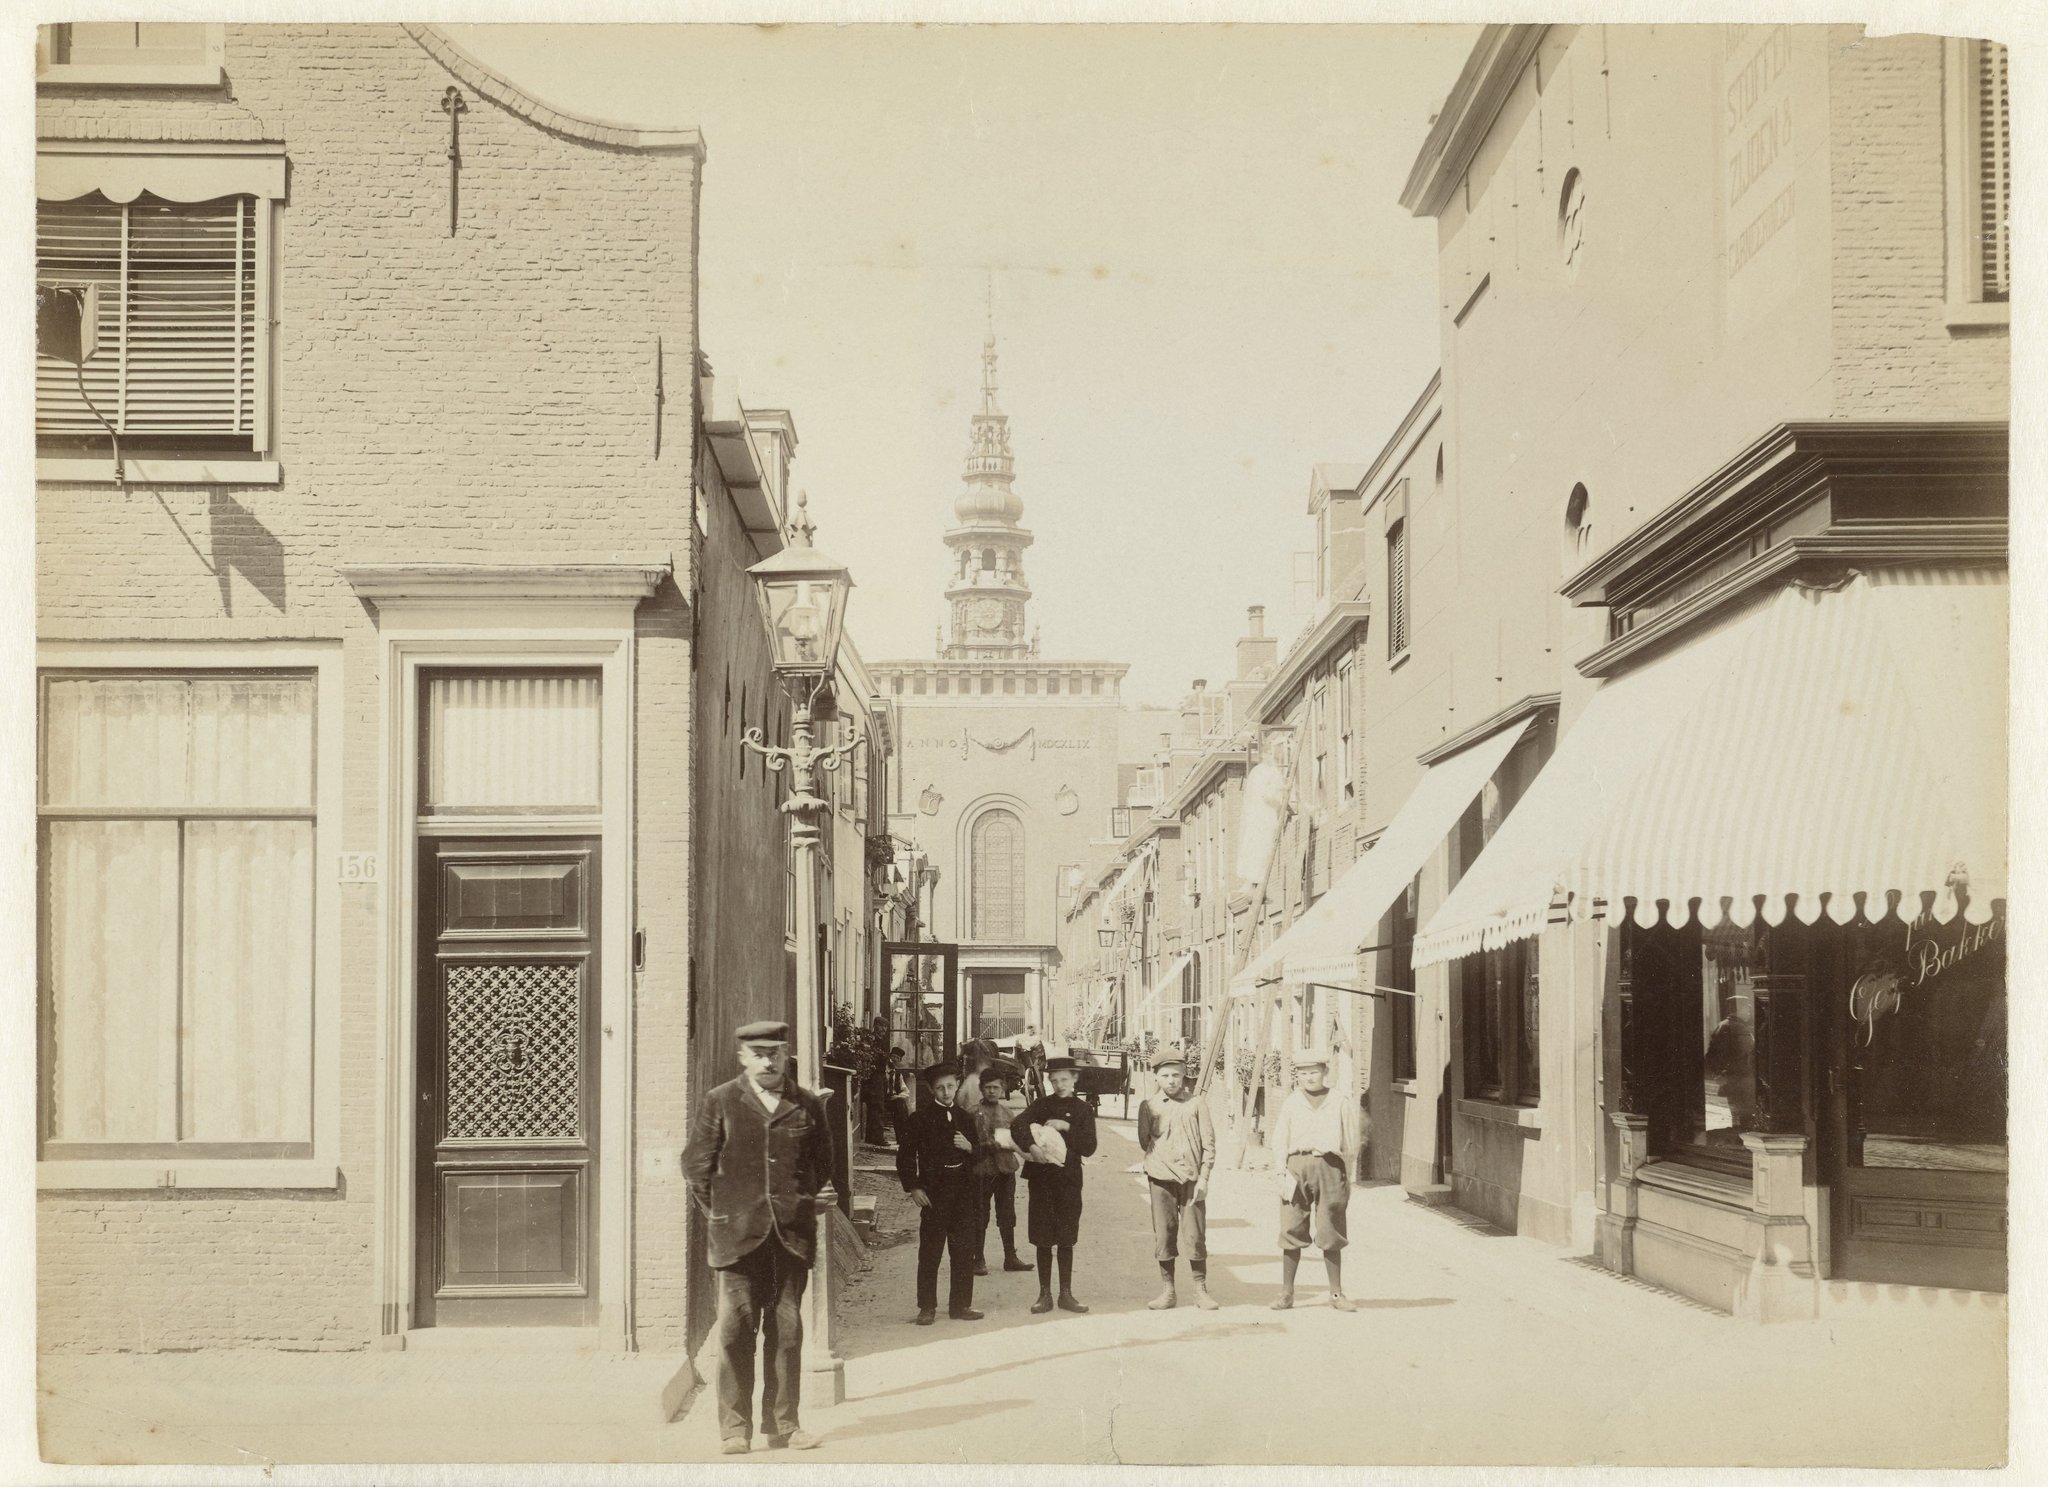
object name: photograph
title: Gezicht op de Kerkstraat te Haarlem, met man en kinderen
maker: Anonymous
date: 1895-1900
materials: paper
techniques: albumen print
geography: amsterdam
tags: street, haarlem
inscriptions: stamp: ‘Gebr. Douwes/ Ateliers/ Warmoesstraat 73/ Amsterdam’, inscription: ‘Dokkum’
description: Onbekende man en kinderen in de Kerkstraat te Haarlem, op de hoek met de Grote Houtstraat. Op de achtergrond de Nieuwe Kerk.